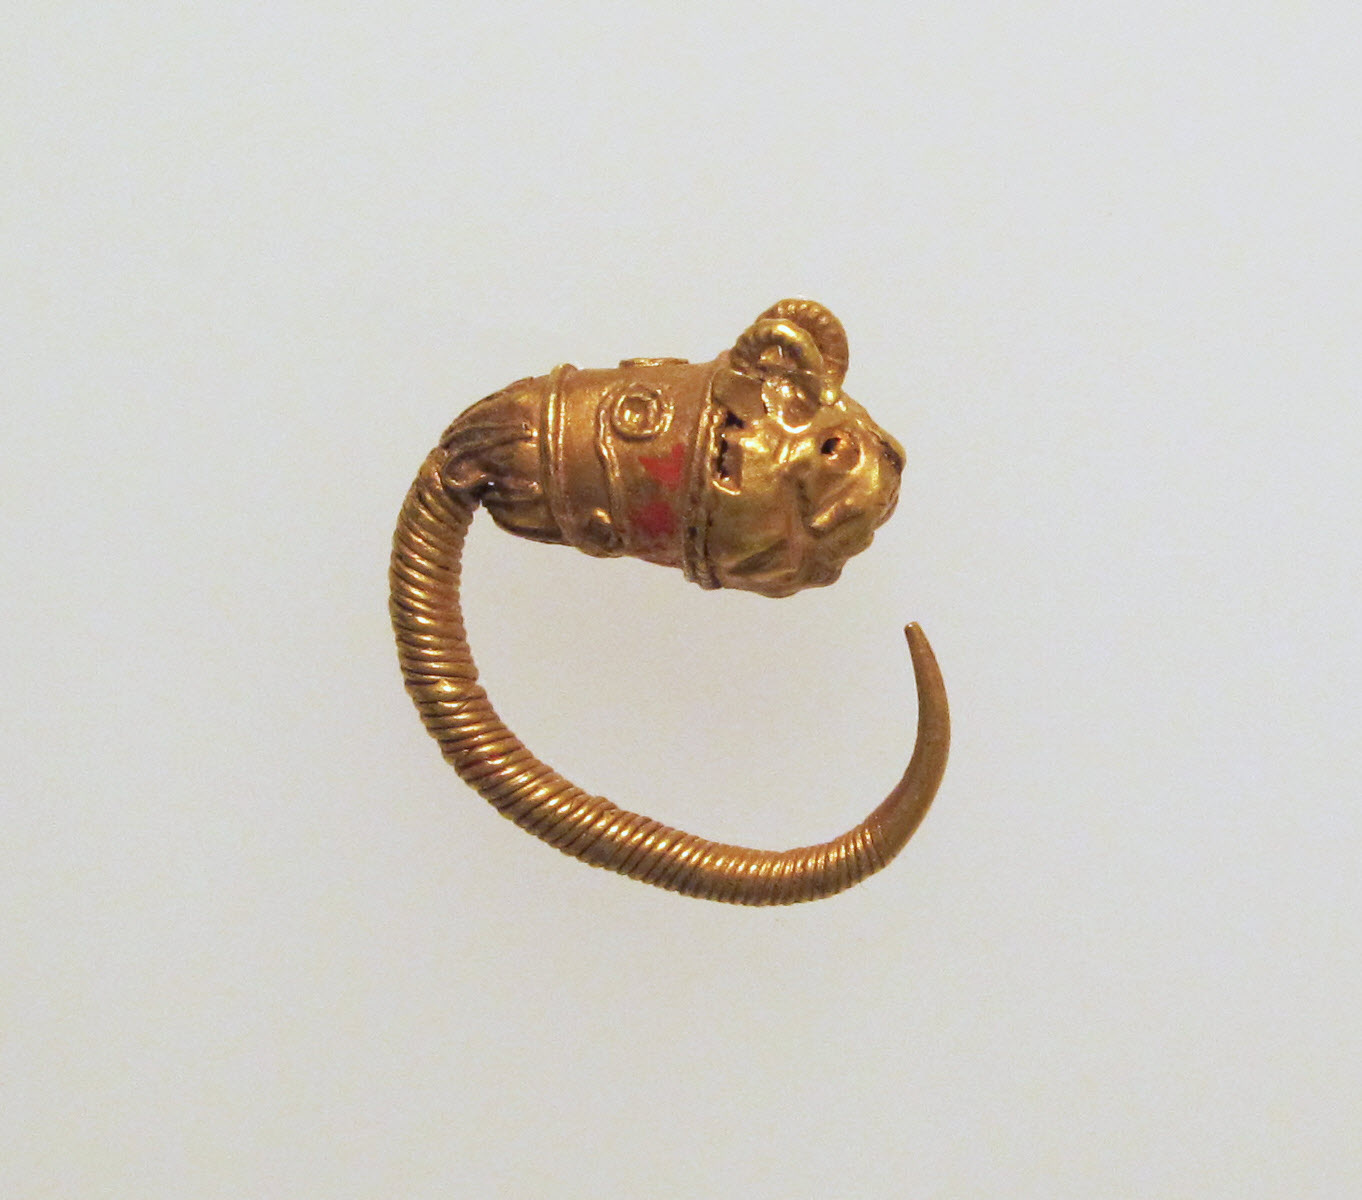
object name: earring with head of lion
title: Gold earring with head of a lion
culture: greek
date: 400-201 BCE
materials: gold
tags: lions